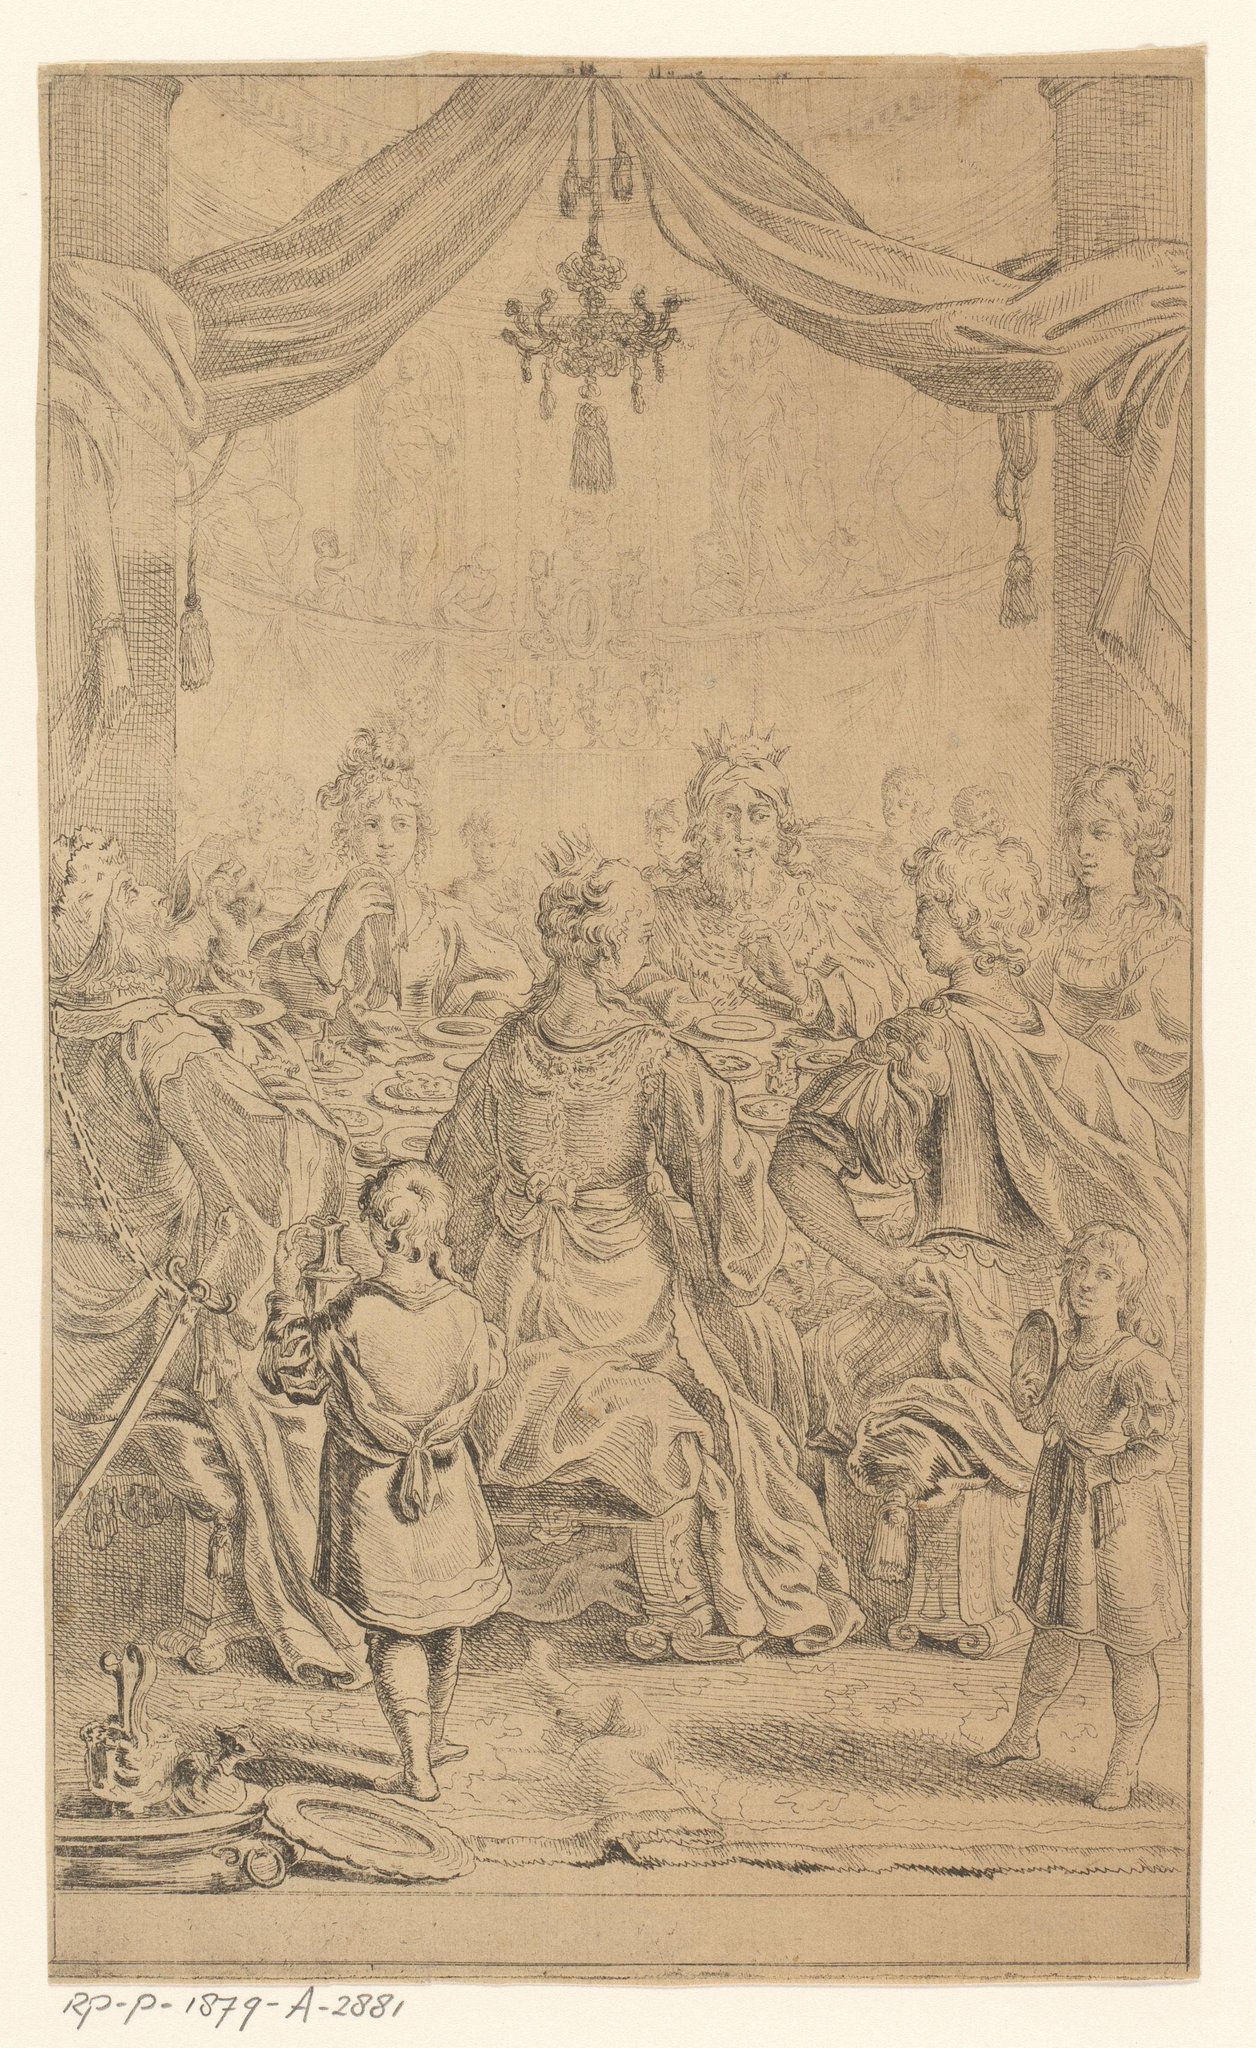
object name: print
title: Koninklijke maaltijd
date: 1646-1715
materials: paper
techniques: etching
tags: queen, empress, etc. (wife of a ruler), celebration meal, feast, banquet, king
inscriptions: collector's mark: Lugt 2228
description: Een koning en koningin zitten aan een maaltijd samen met hun gasten onder een baldakijn. Op de voorgrond twee pages, de een met een kan, de ander met een schaal.